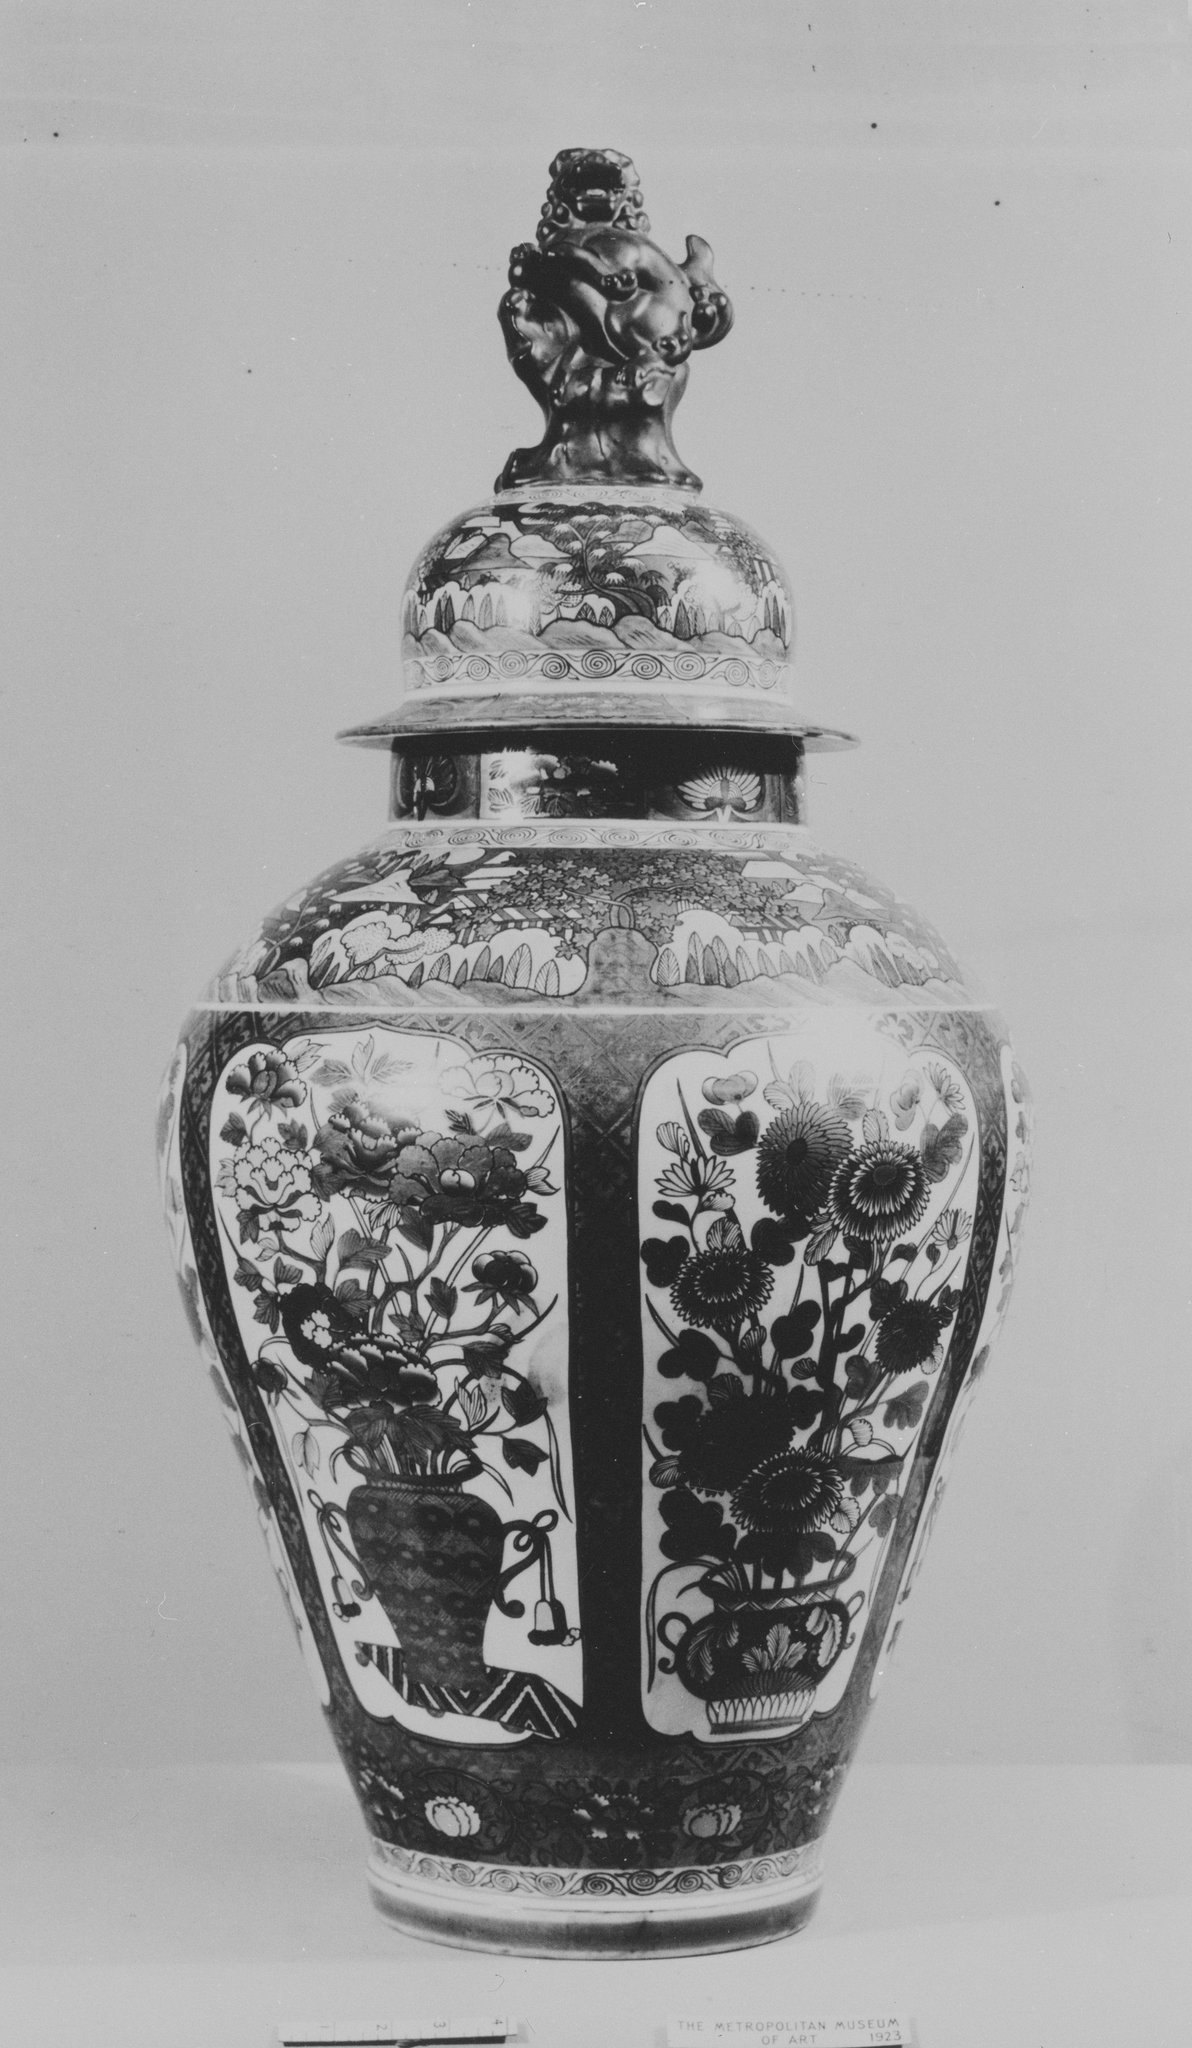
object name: vase with cover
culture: japanese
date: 1680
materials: enamel, gold, porcelain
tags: flowers,plants